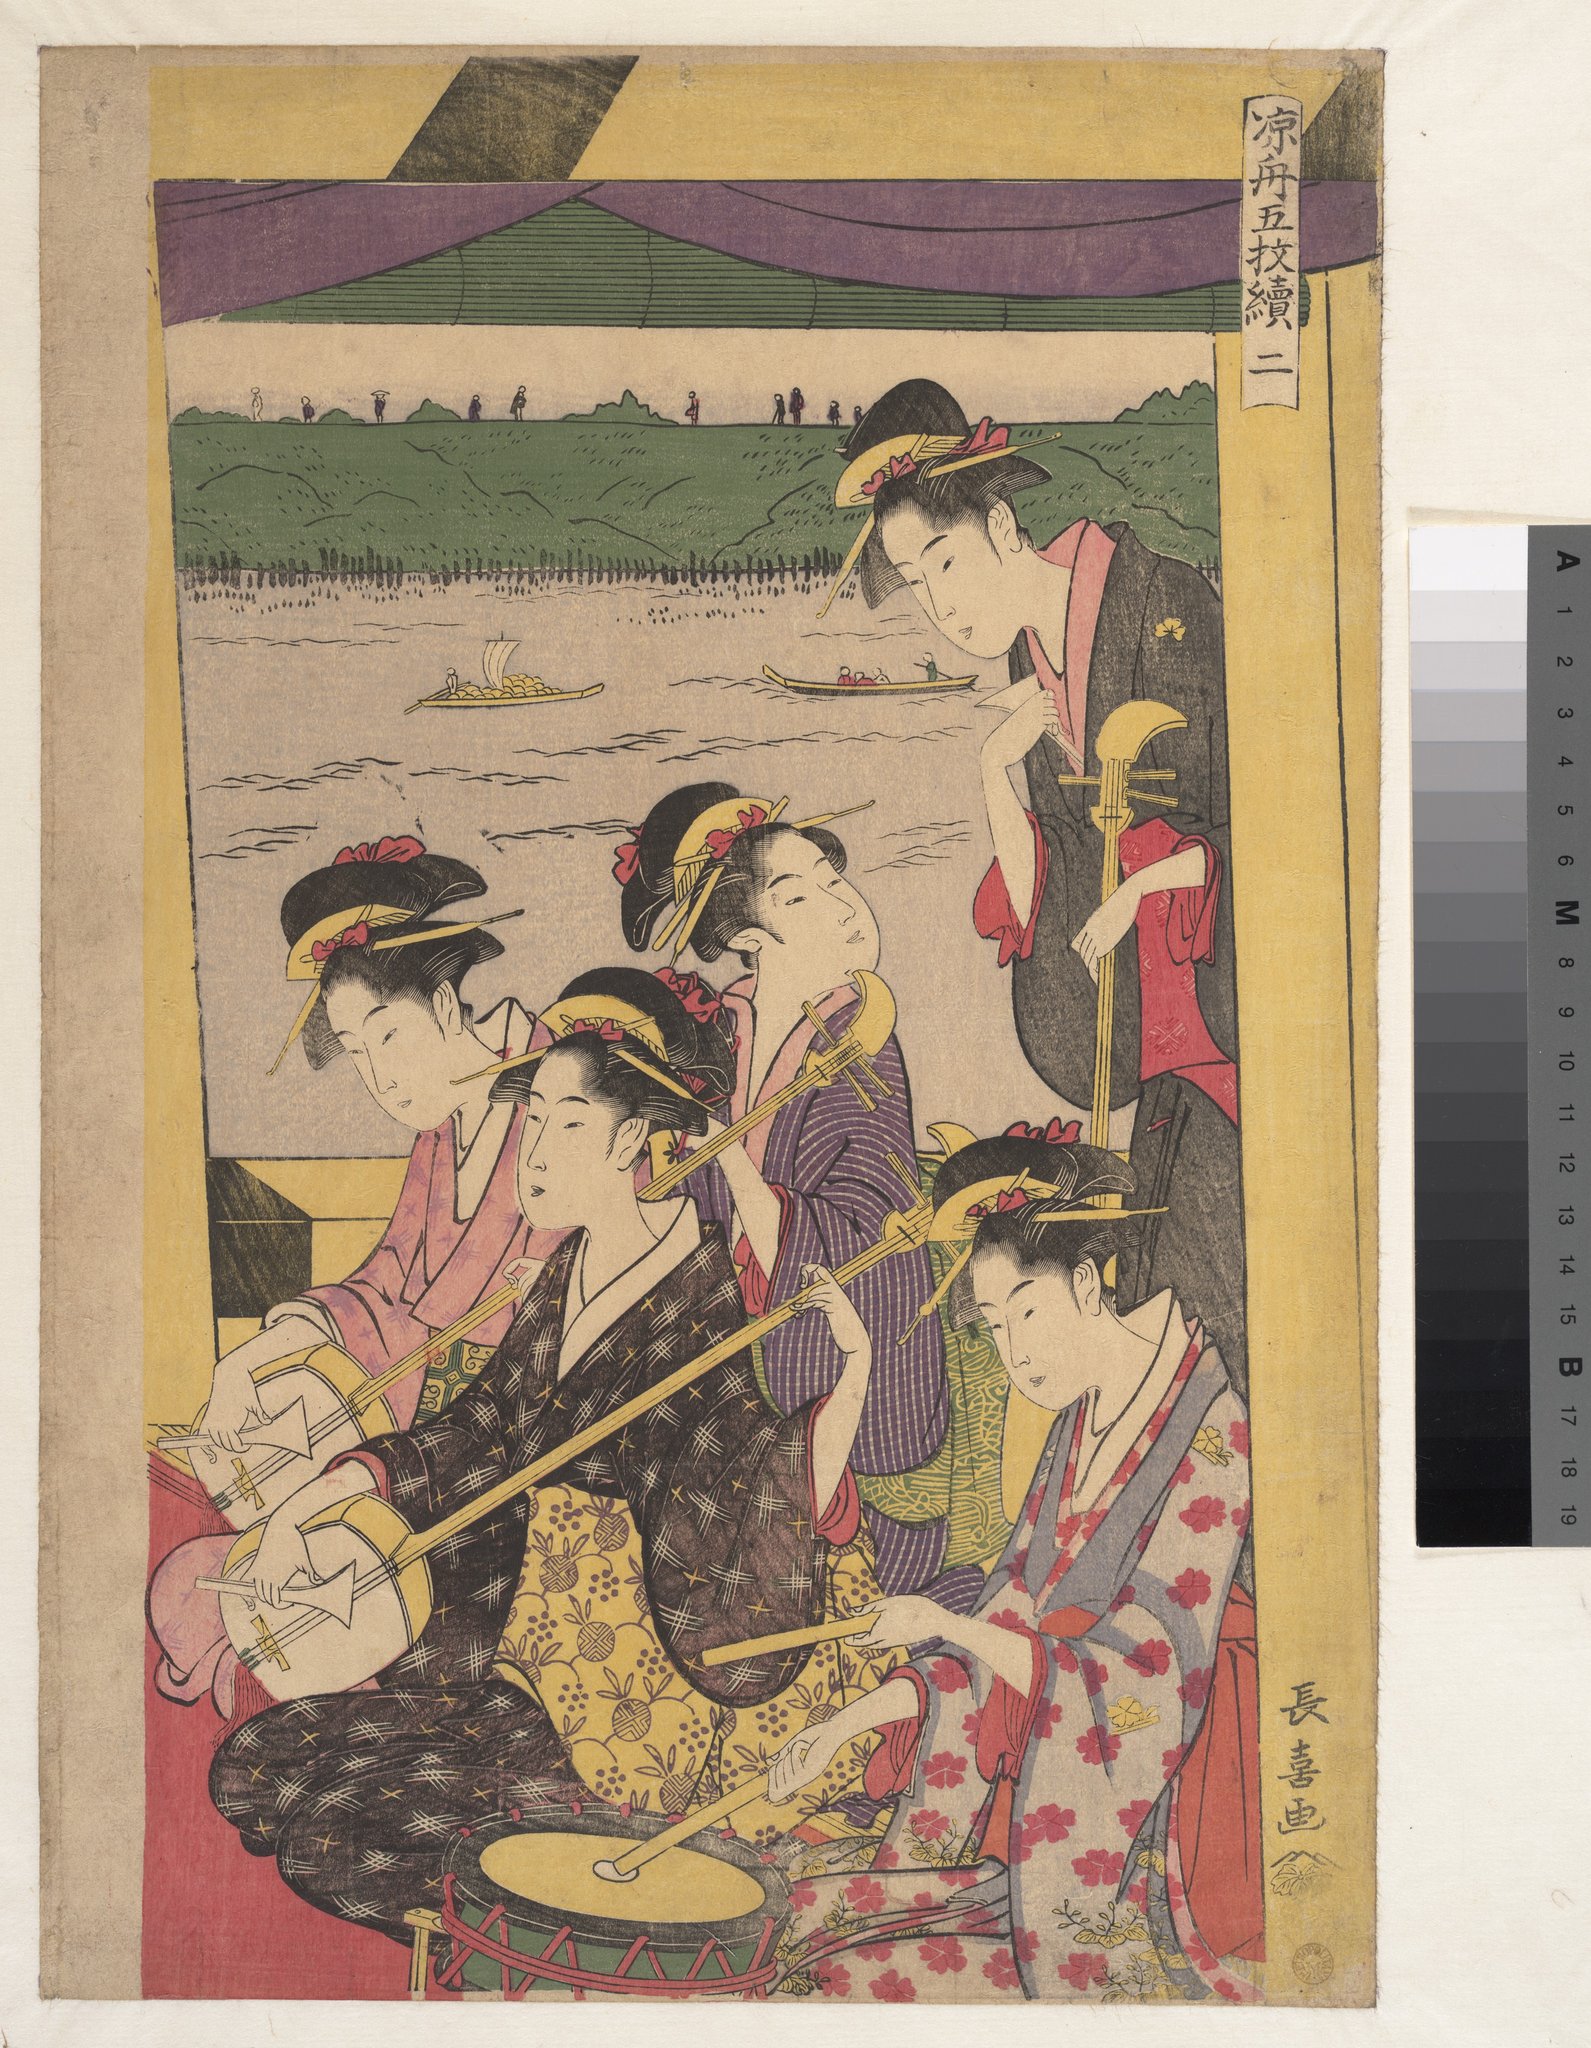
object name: print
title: A Party of Geisha in a Suzumi-bune, i.e. "cooling-off boat." (Second Scene of a Boating Party)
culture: japanese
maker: eishōsai chōki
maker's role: artist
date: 1796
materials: ink, paper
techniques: woodblock print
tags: musical instruments,women,boats